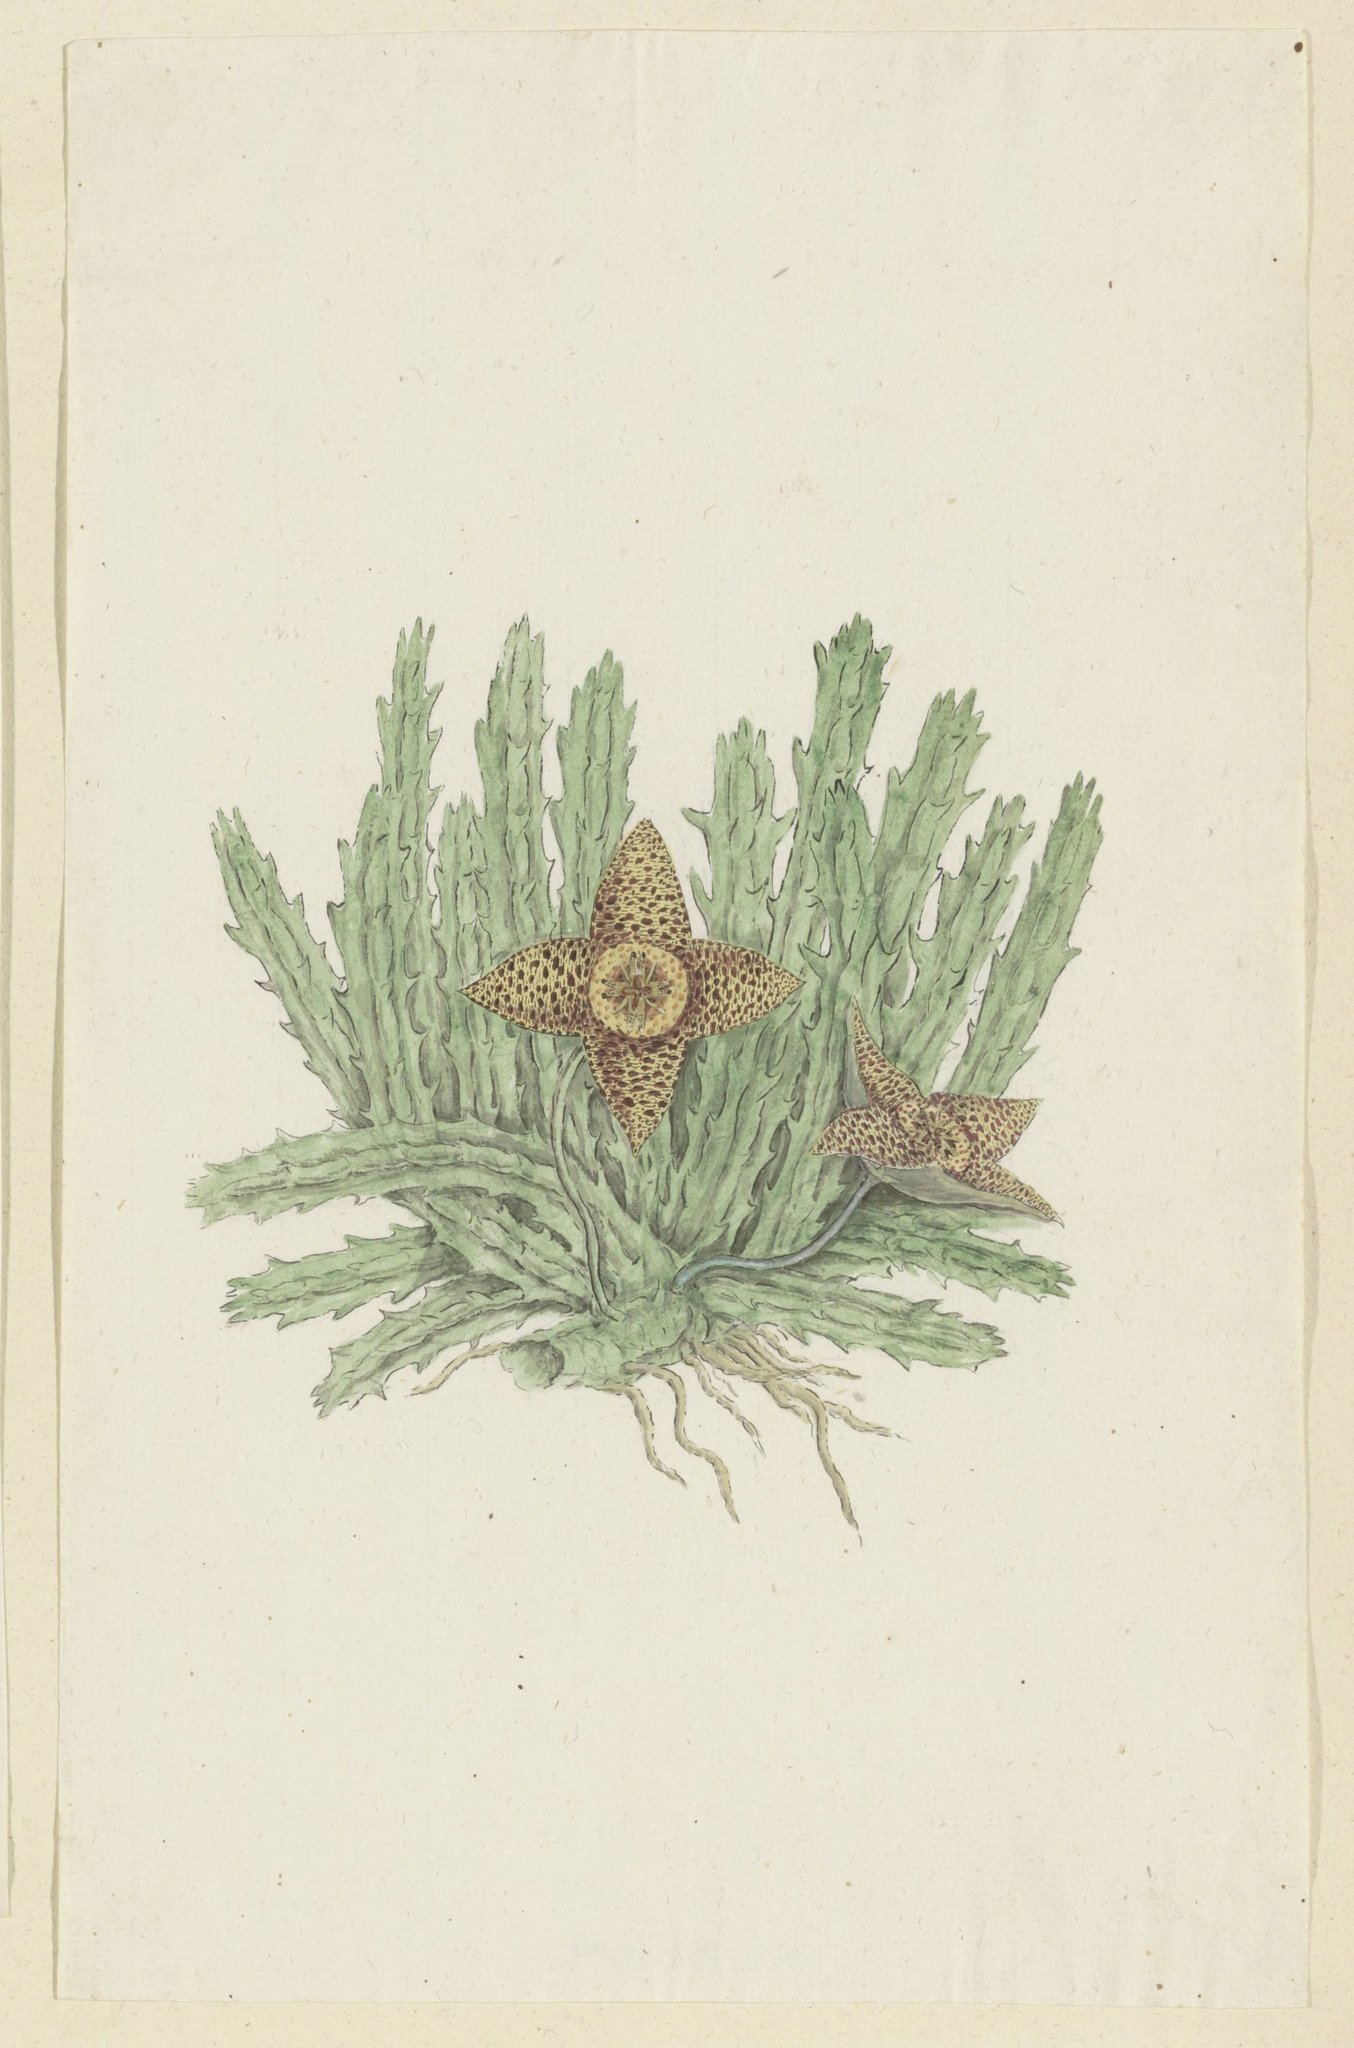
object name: drawing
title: Huernia namaquensis Pillans. (Namaqua carrion-flower)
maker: robert jacob gordon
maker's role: draughtsman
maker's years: 1743-1795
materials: chalk, ink, paper, pencil, watercolor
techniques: brush, pen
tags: plants; vegetation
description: De tekening is gemaakt voor of tijdens een van Gordon's vier expedities door de Kaapprovincie, van oktober 1777 tot maart 1786. Sommige (soort)namen kunnen zijn gewijzigd, gezien reorganisatie in plantentaxonomie gedurende de afgelopen jaren.